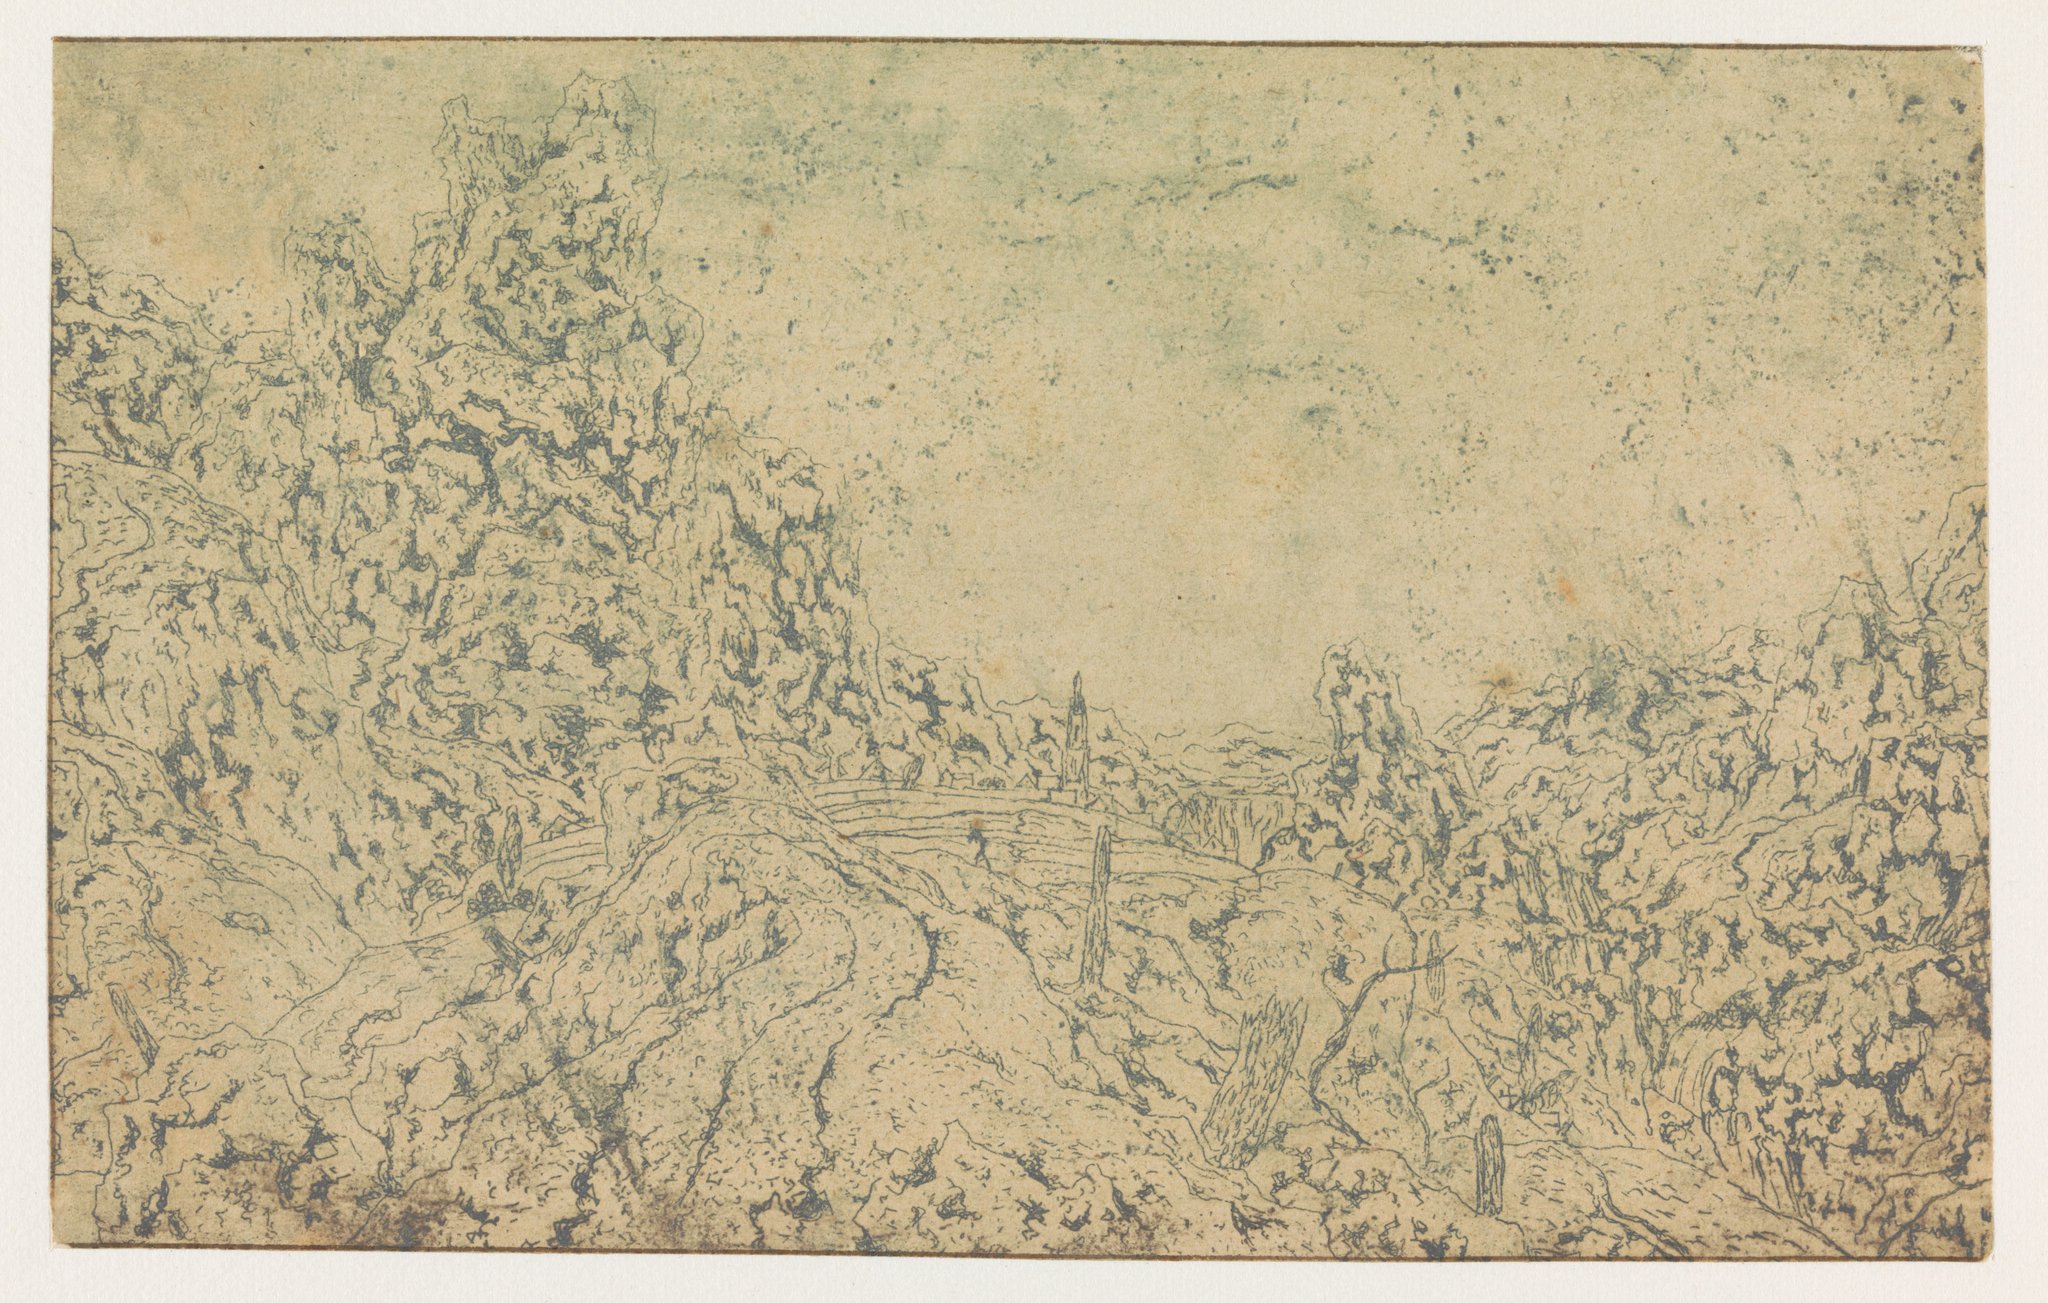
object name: print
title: Rocky Landscape with a Village and a Tall Tower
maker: hercules segers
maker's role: draughtsman, painter, print maker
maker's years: 1589-1640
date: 1623-1625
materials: paper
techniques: etching, intaglio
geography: amsterdam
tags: landscape with other man-made constructions not mentioned above, e.g.: graveyards, playgrounds, etc., rocks